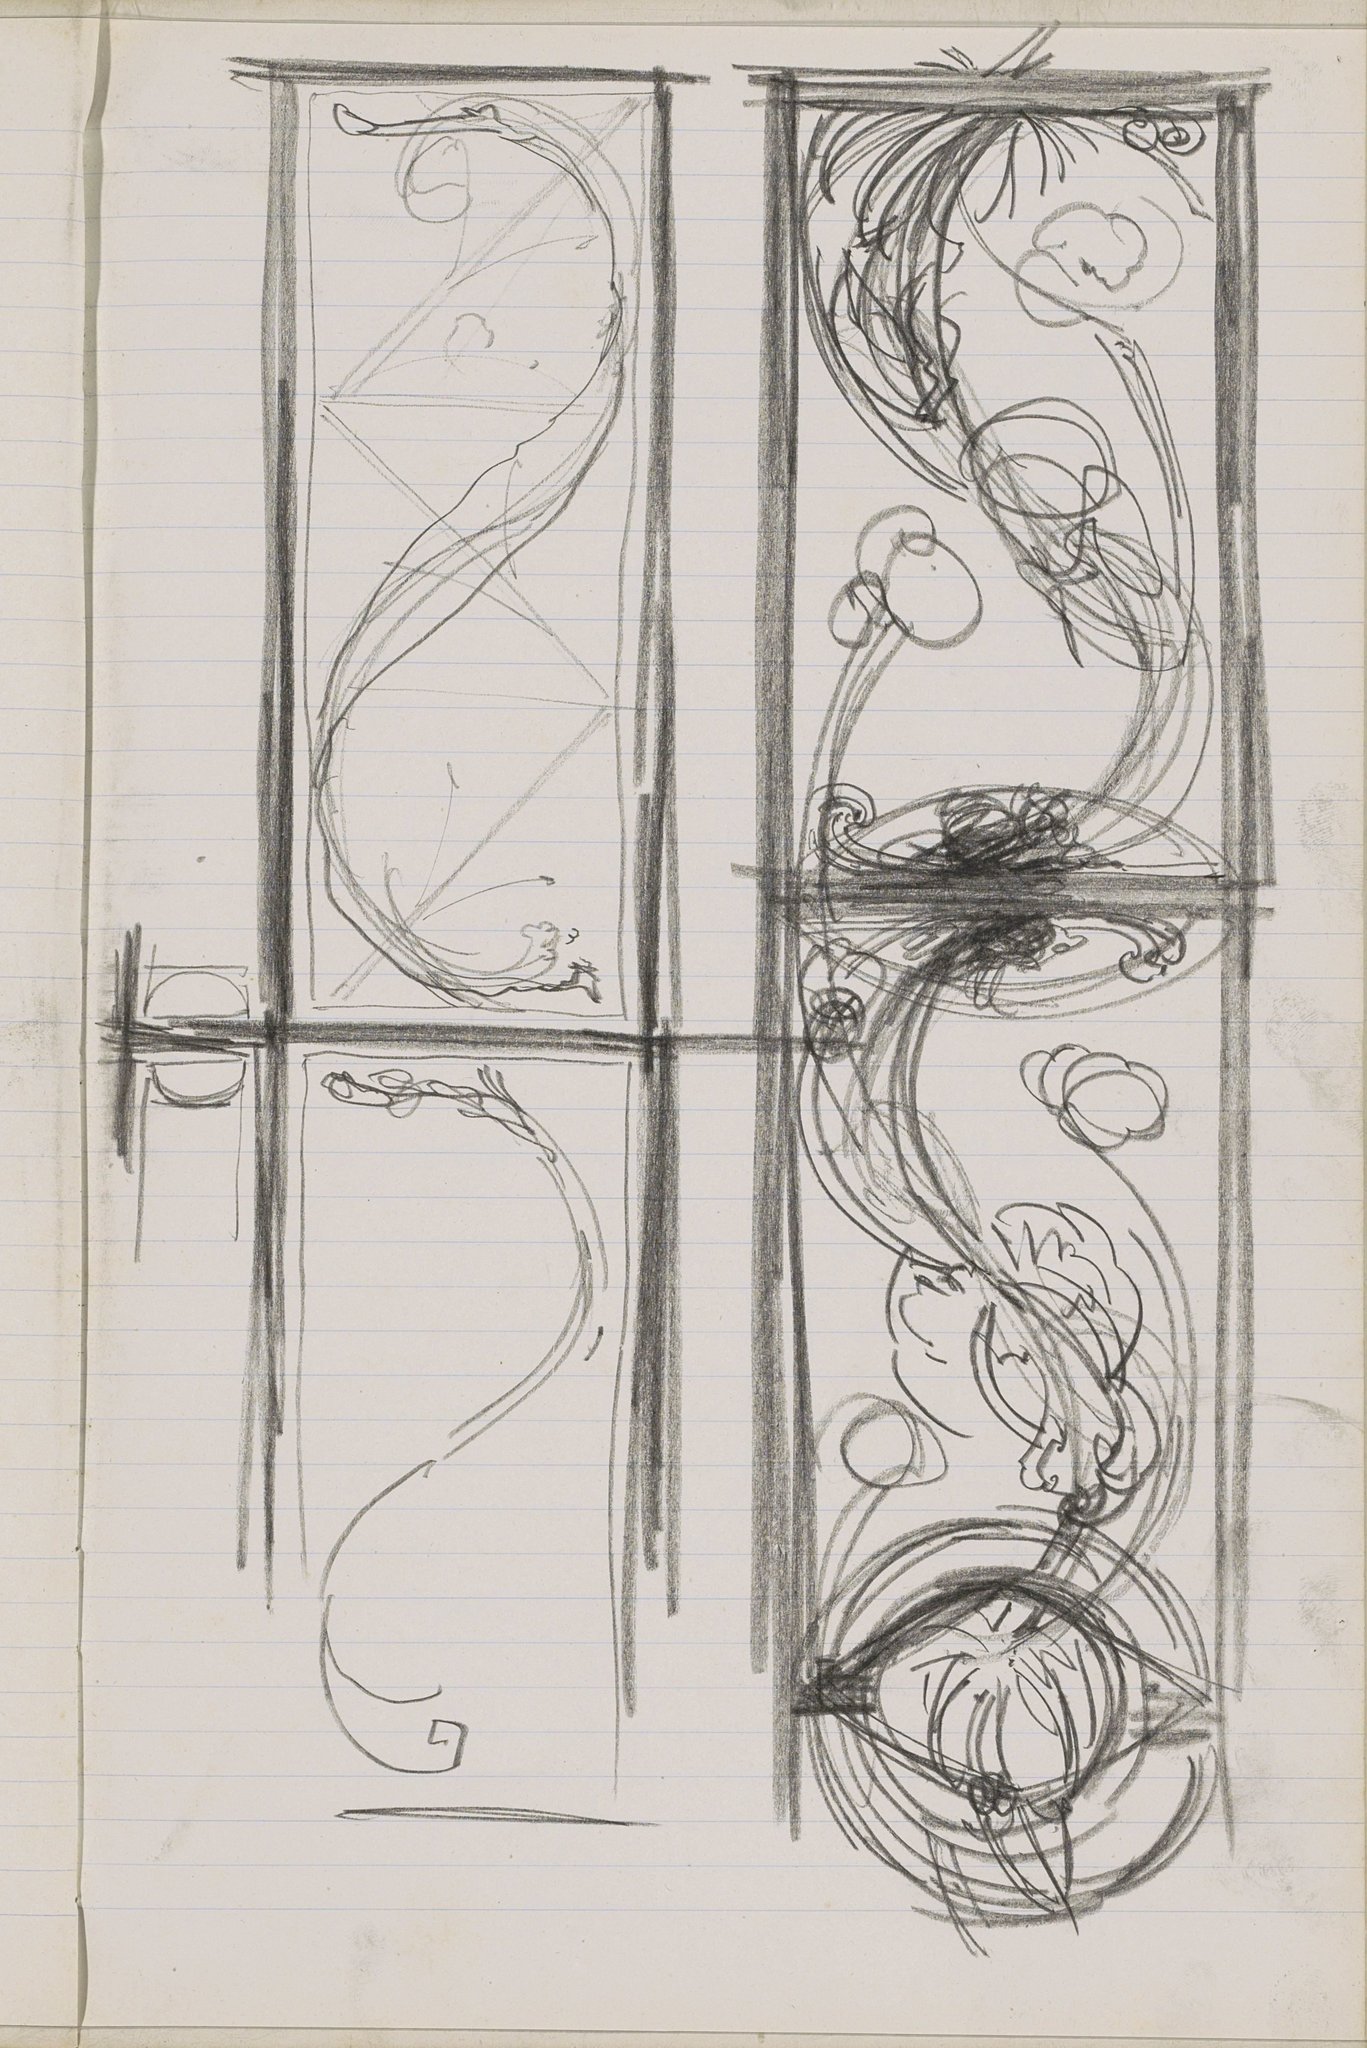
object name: sketchbook leaf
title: Ornamenten met bloemen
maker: gerrit willem dijsselhof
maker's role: designer, draughtsman, print maker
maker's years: 1866-1924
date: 1901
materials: chalk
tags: flowers ~ ornament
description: Blad 22 recto uit een schetsboek met 79 bladen.